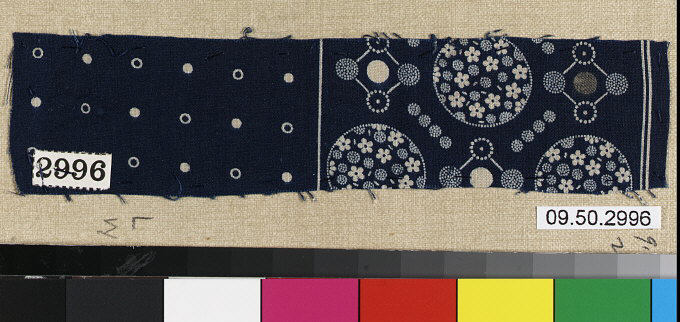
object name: piece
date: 1801-1900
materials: cotton